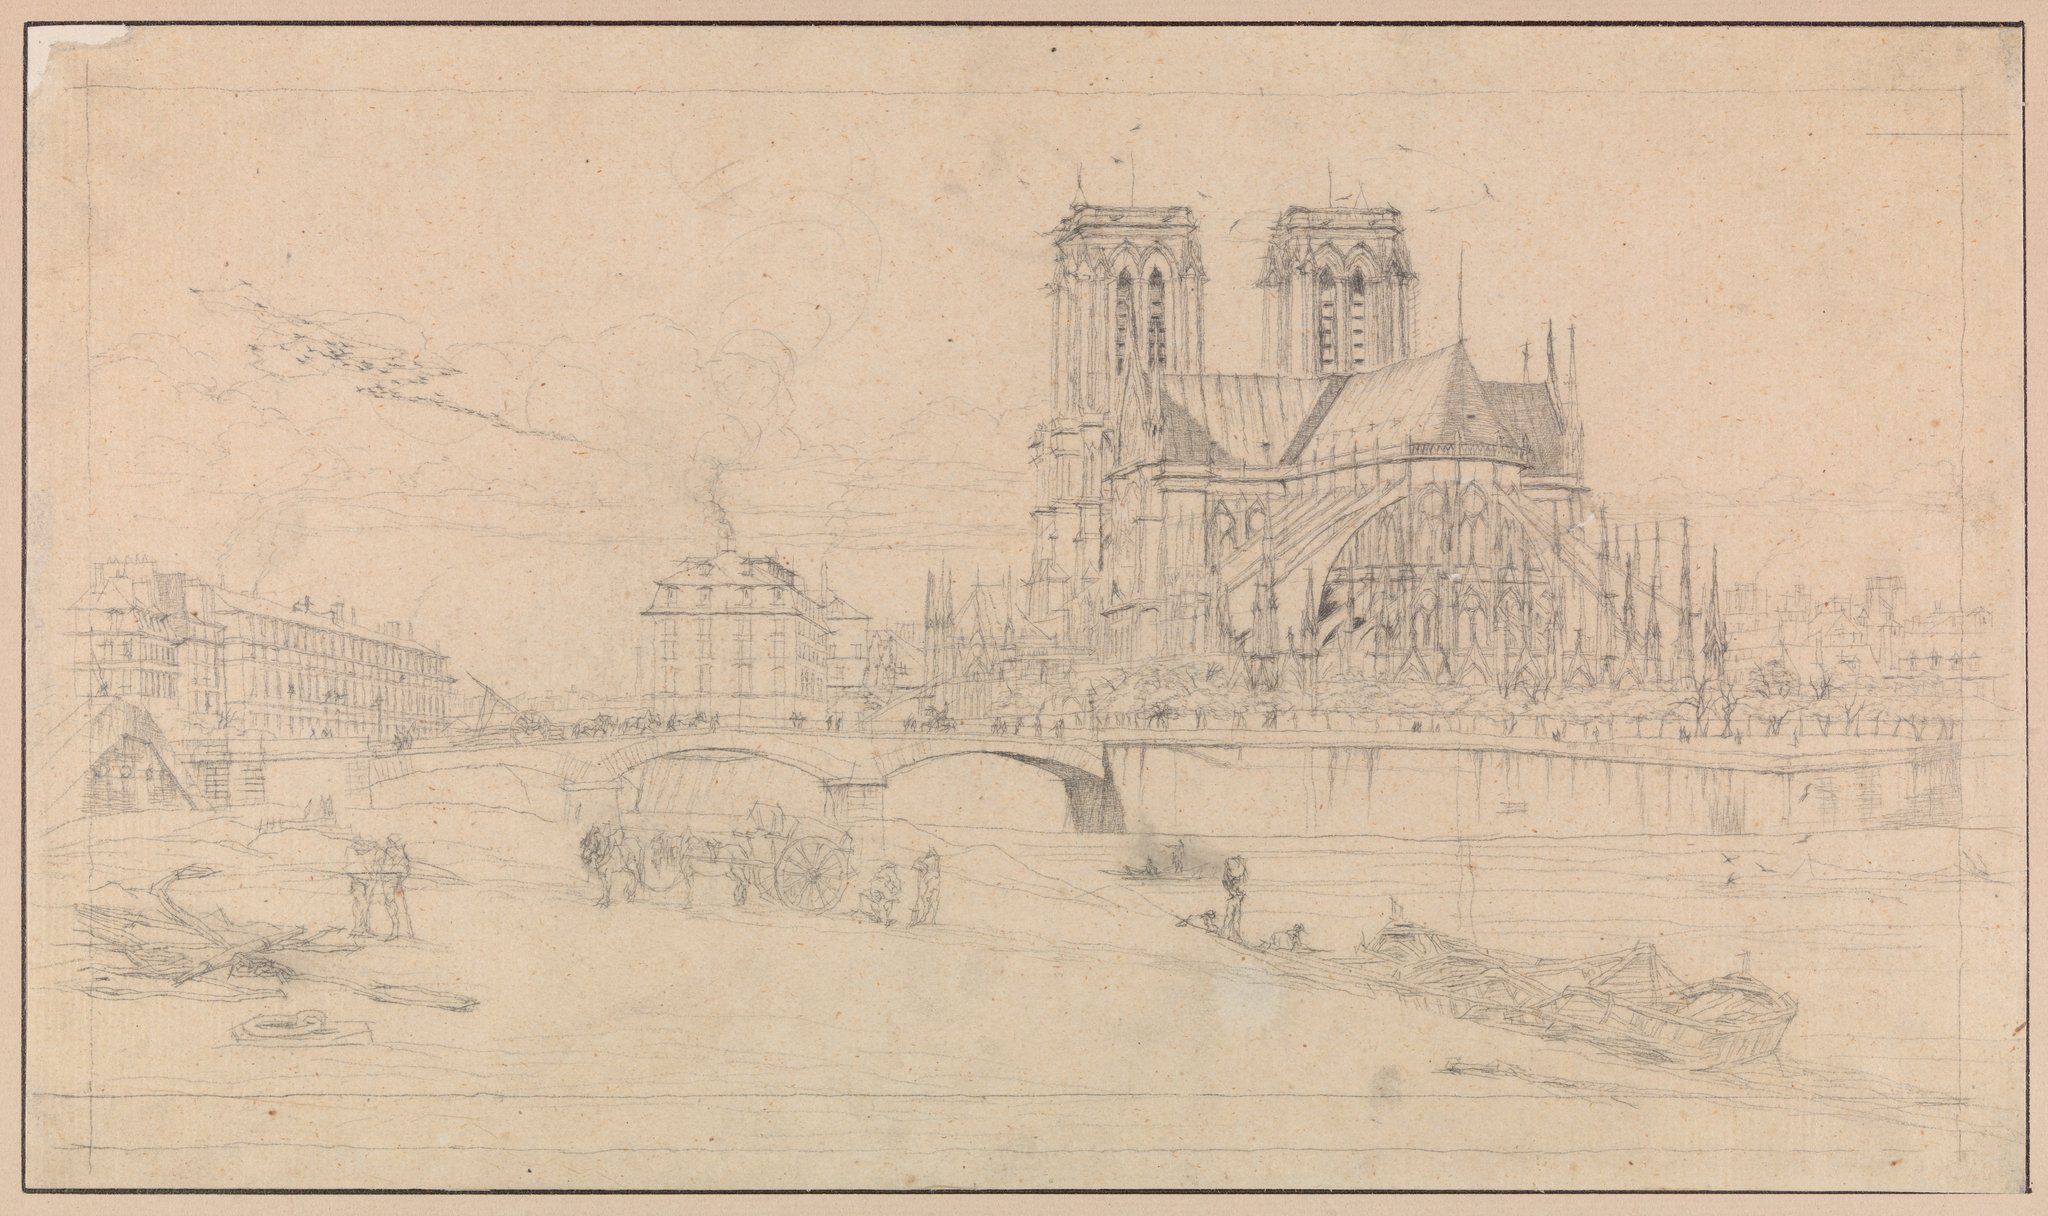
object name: drawing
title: The Apse of Notre-Dame, Paris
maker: charles meryon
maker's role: artist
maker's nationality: french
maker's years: 1821-1868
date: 1852-1854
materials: graphite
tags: cathedrals,paris